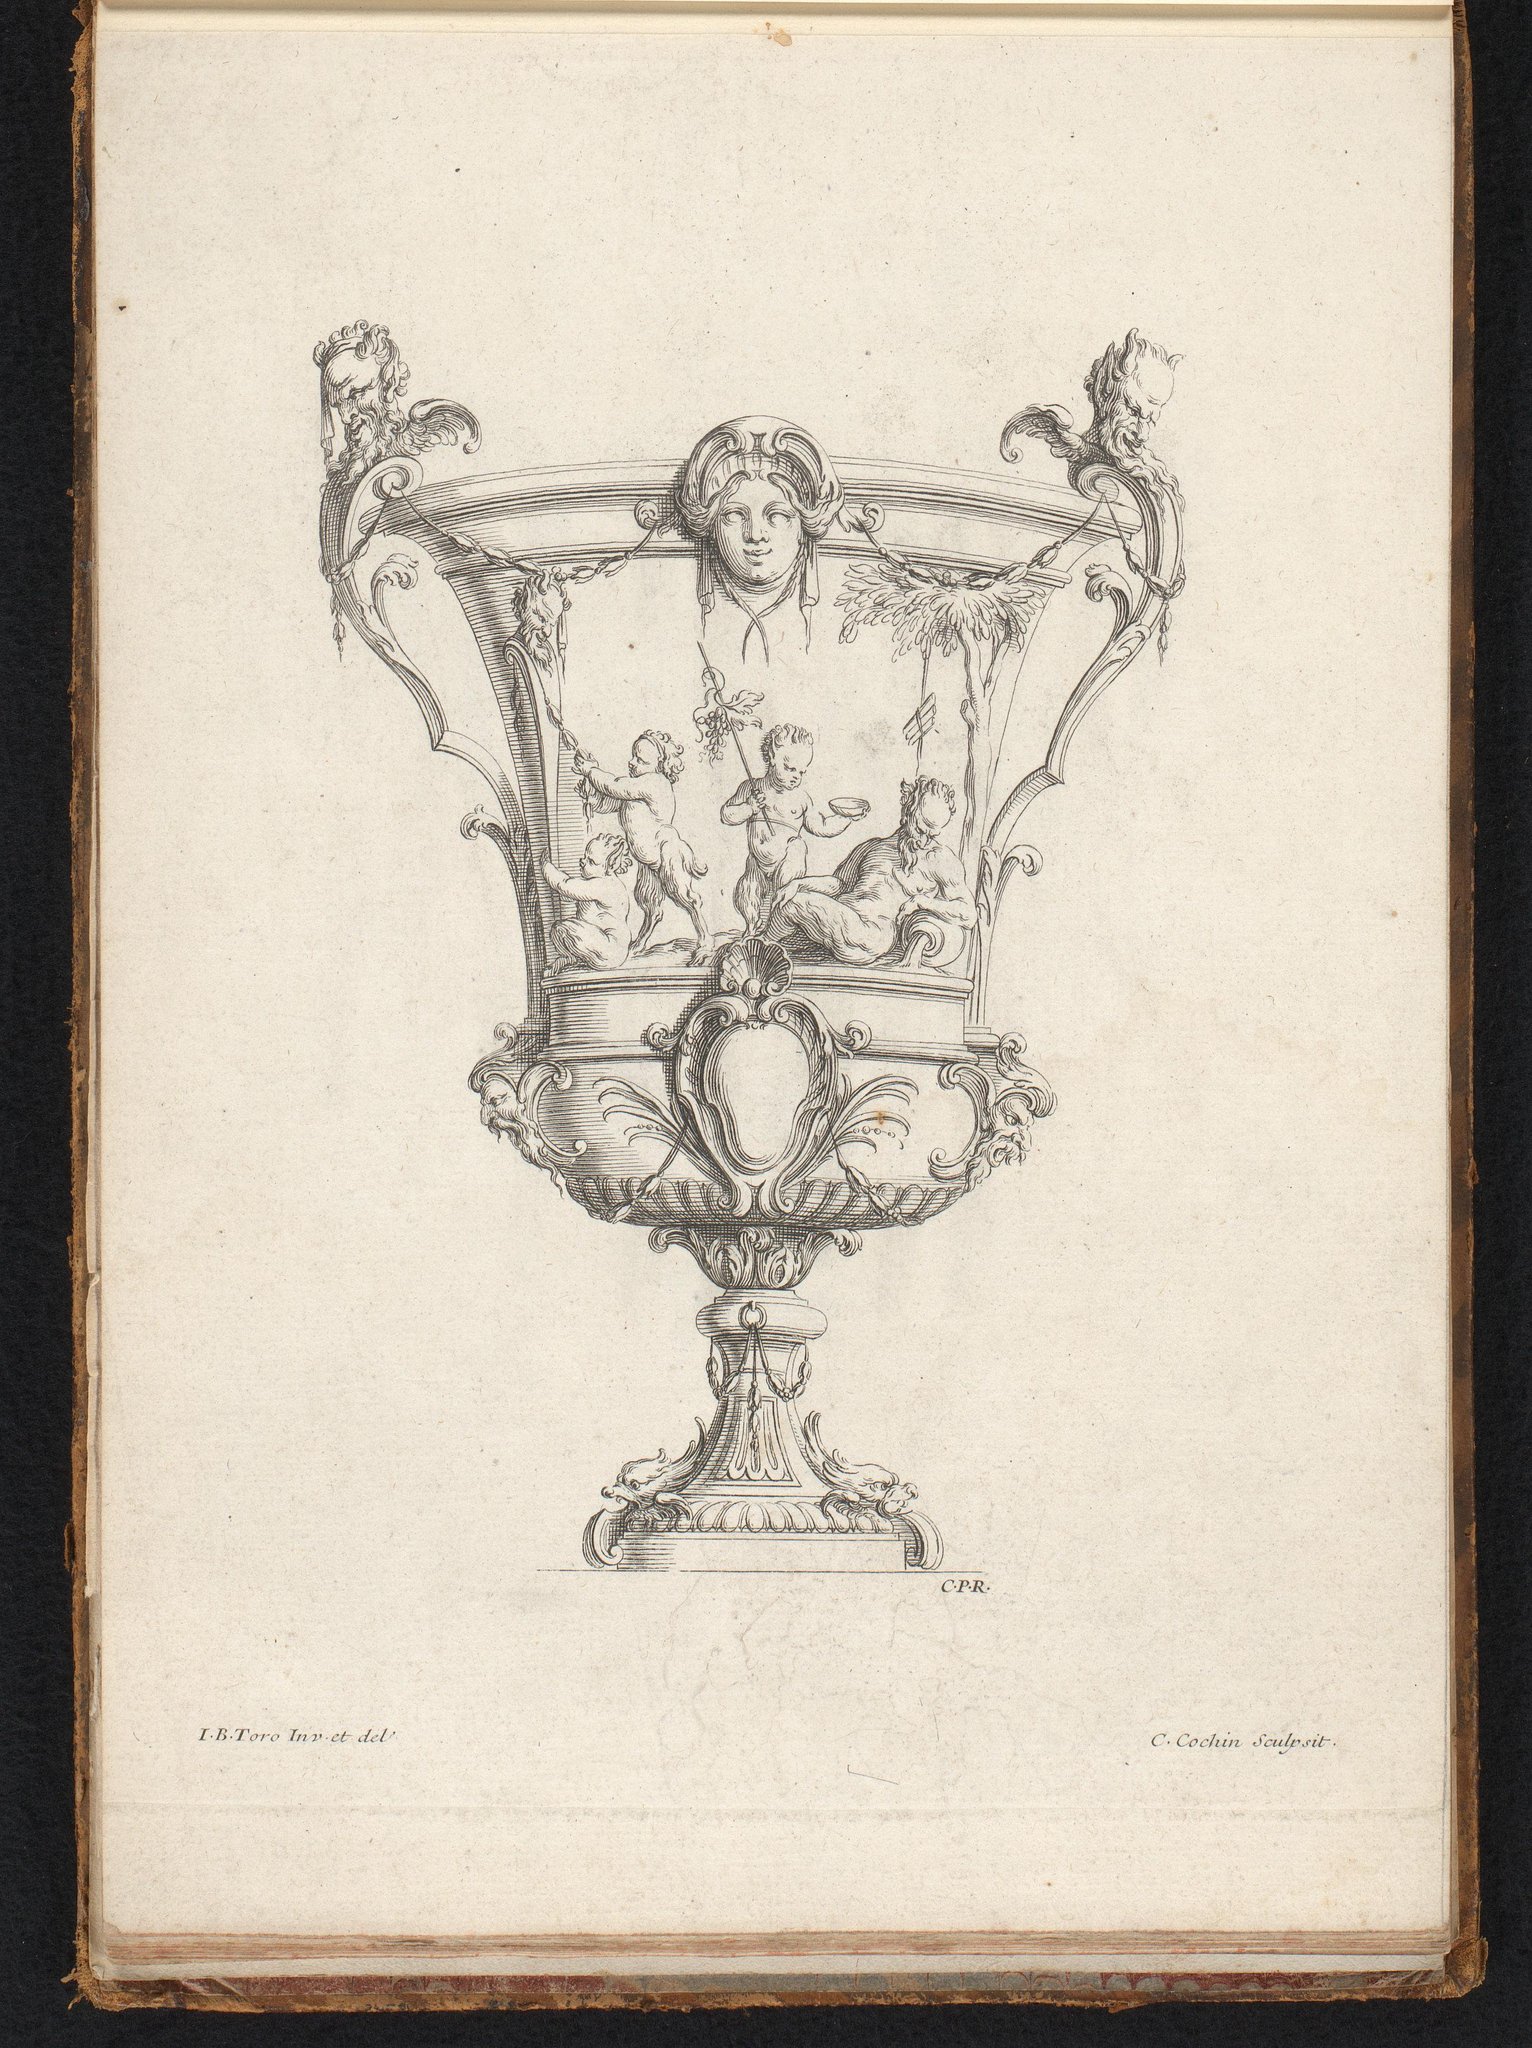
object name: print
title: Nouveau Livre de Vases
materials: paper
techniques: engraving, etching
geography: france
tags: vase ~ ornament, satyr(s) (in general), garden vase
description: Prent maakt deel uit van een serie van zeven prenten.